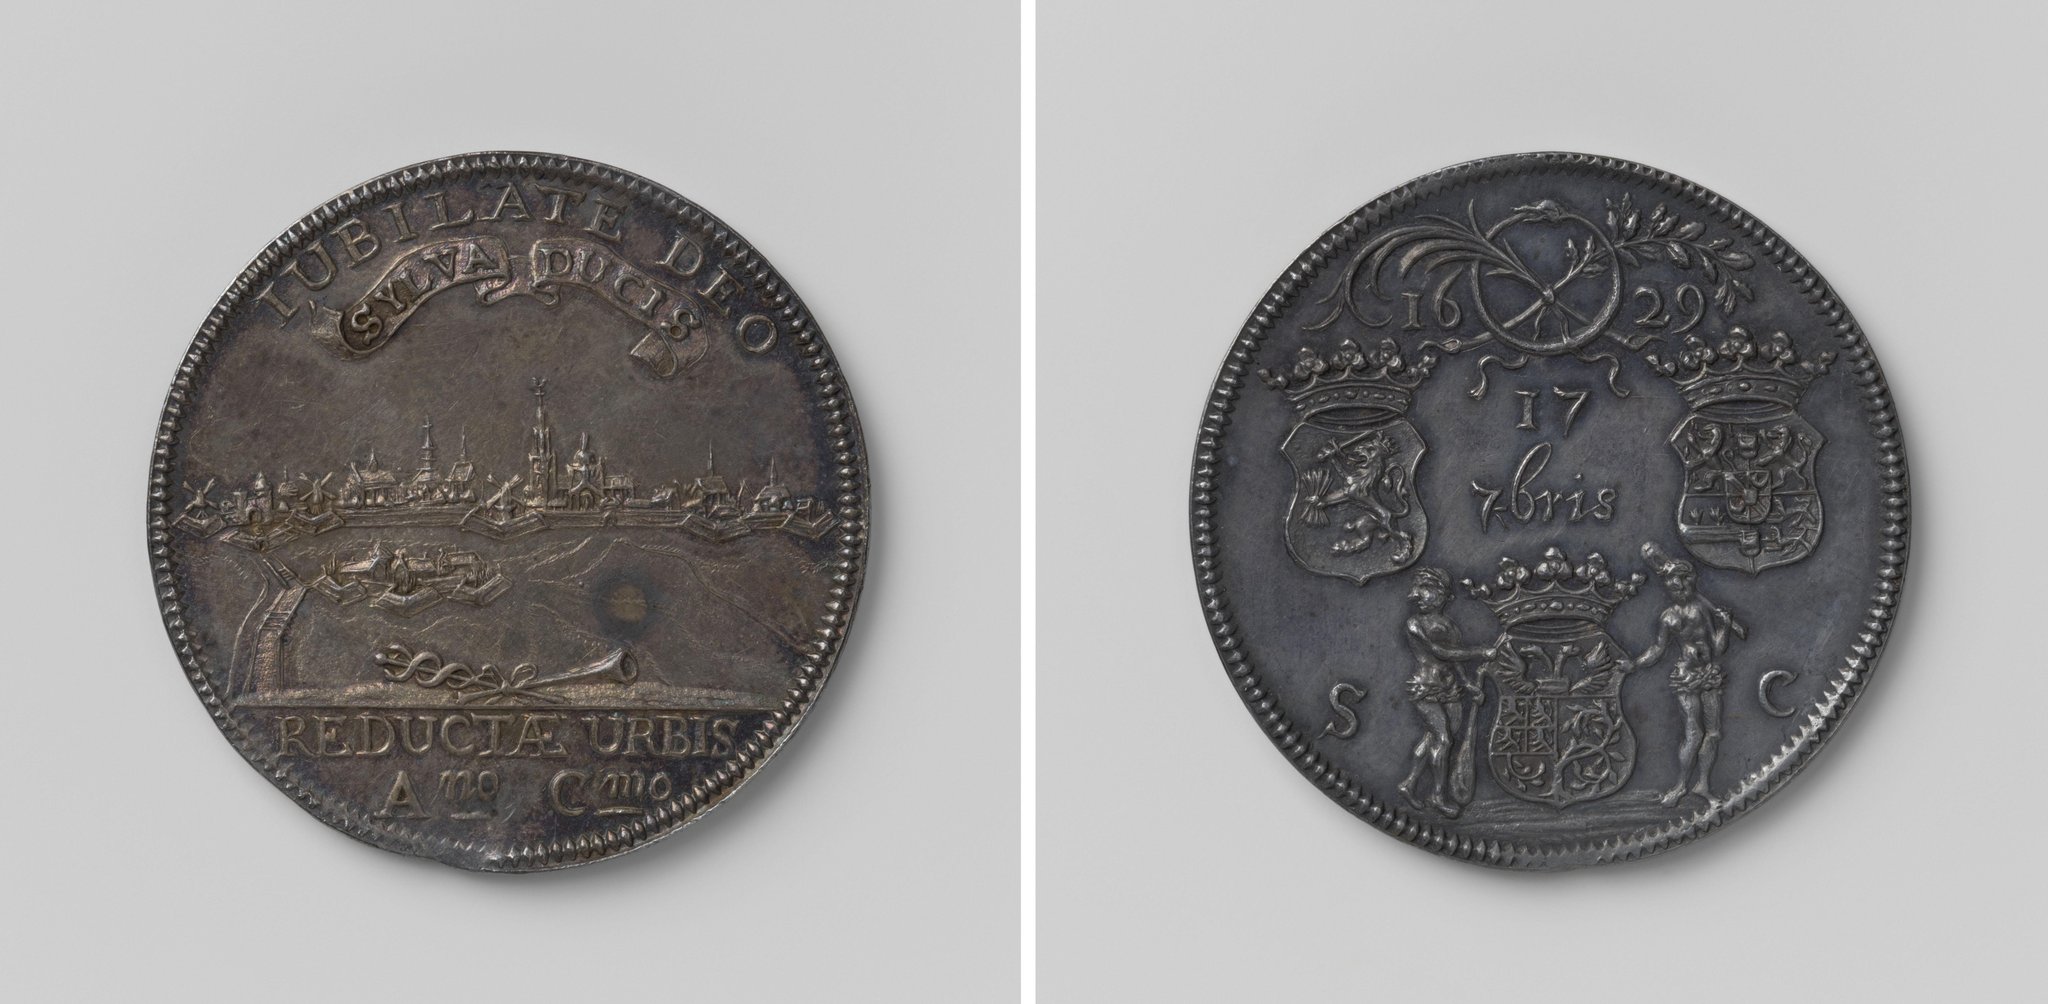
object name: council medal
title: 's-Hertogenbosch, vroedschapspenning op het eeuwfeest van de inname van de stad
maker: theodorus casparus van berckel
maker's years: 1680-1734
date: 1729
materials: silver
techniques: striking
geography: den bosch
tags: den bosch